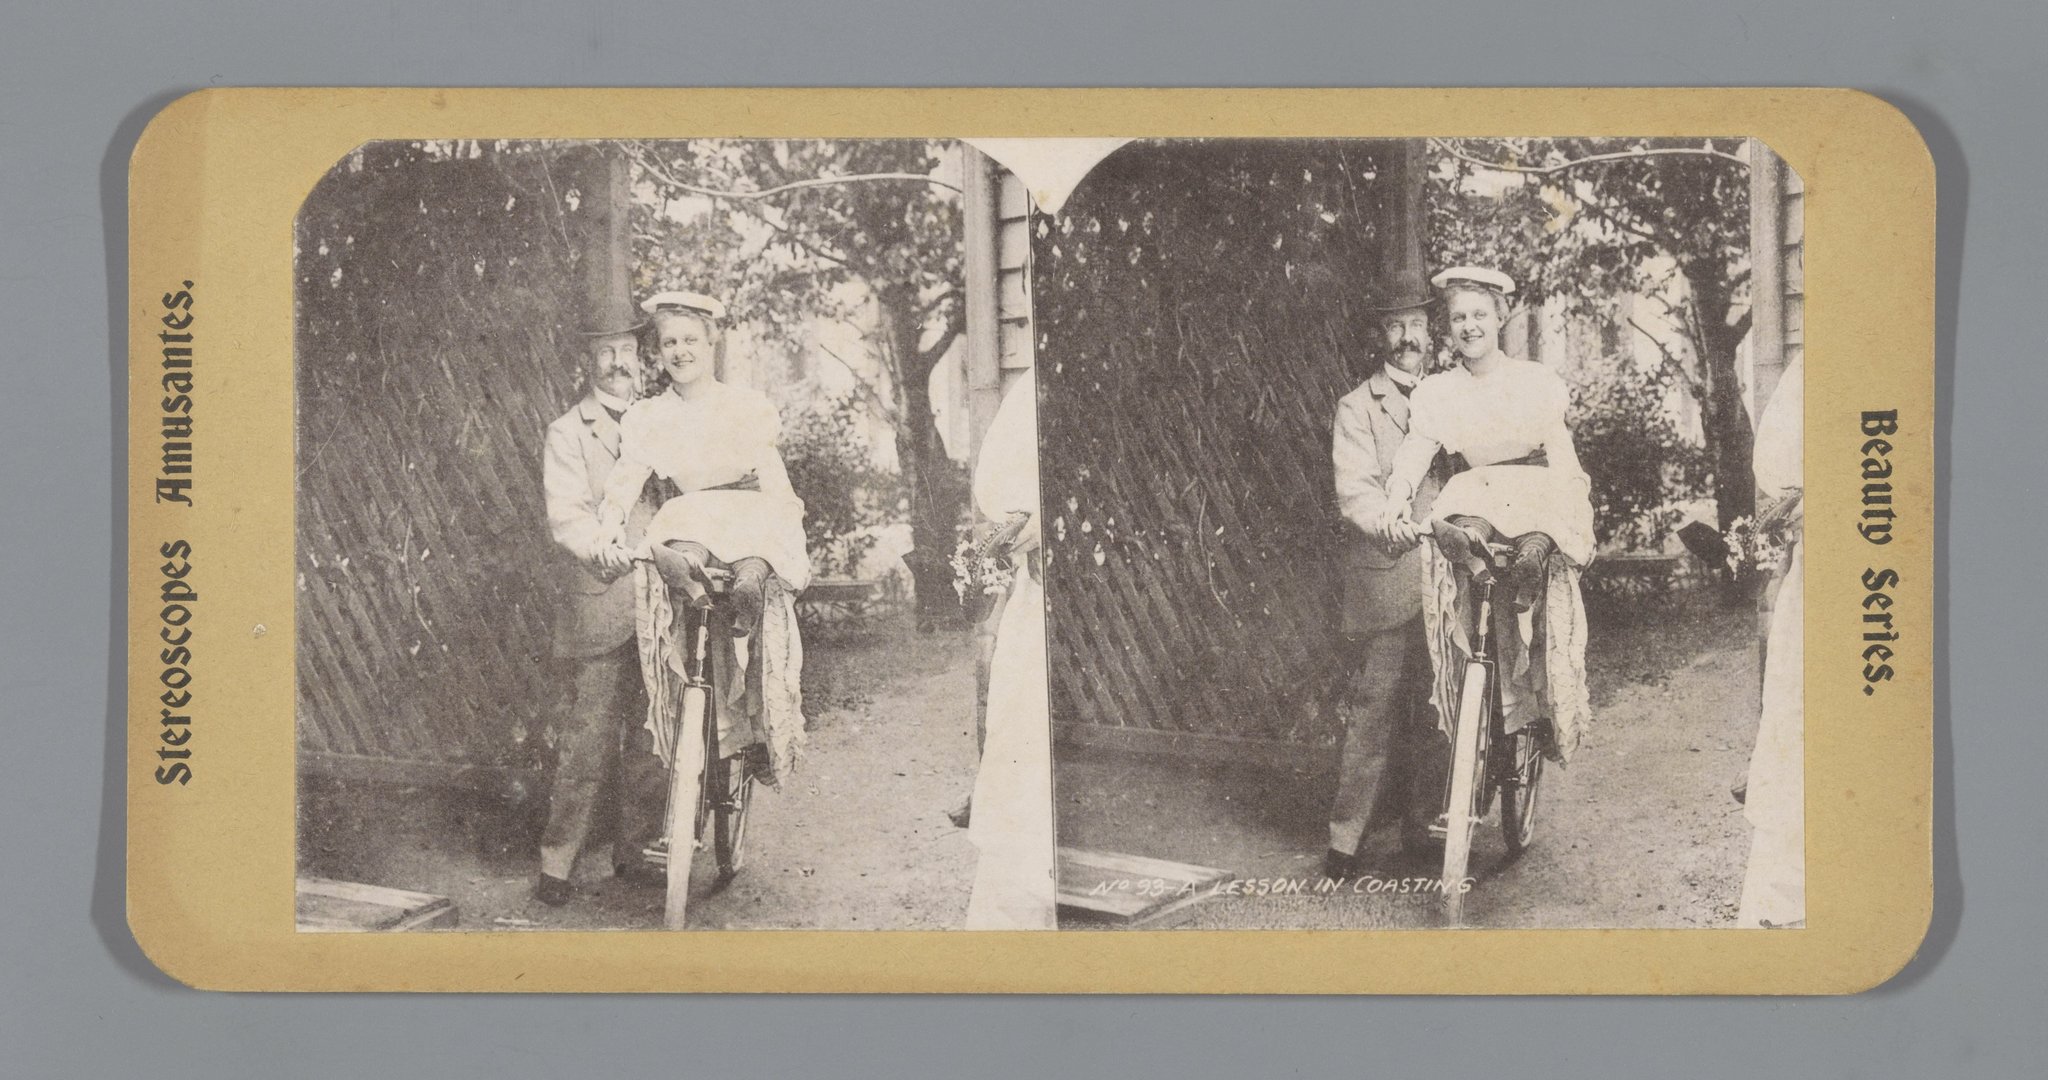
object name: photomechanical print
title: A Lesson in Coasting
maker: Anonymous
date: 1885-1920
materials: cardboard, photographic support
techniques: photograph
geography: united states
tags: adult woman, adult man, bicycle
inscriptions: number: ‘No 93’, retailer's mark: ‘JK’